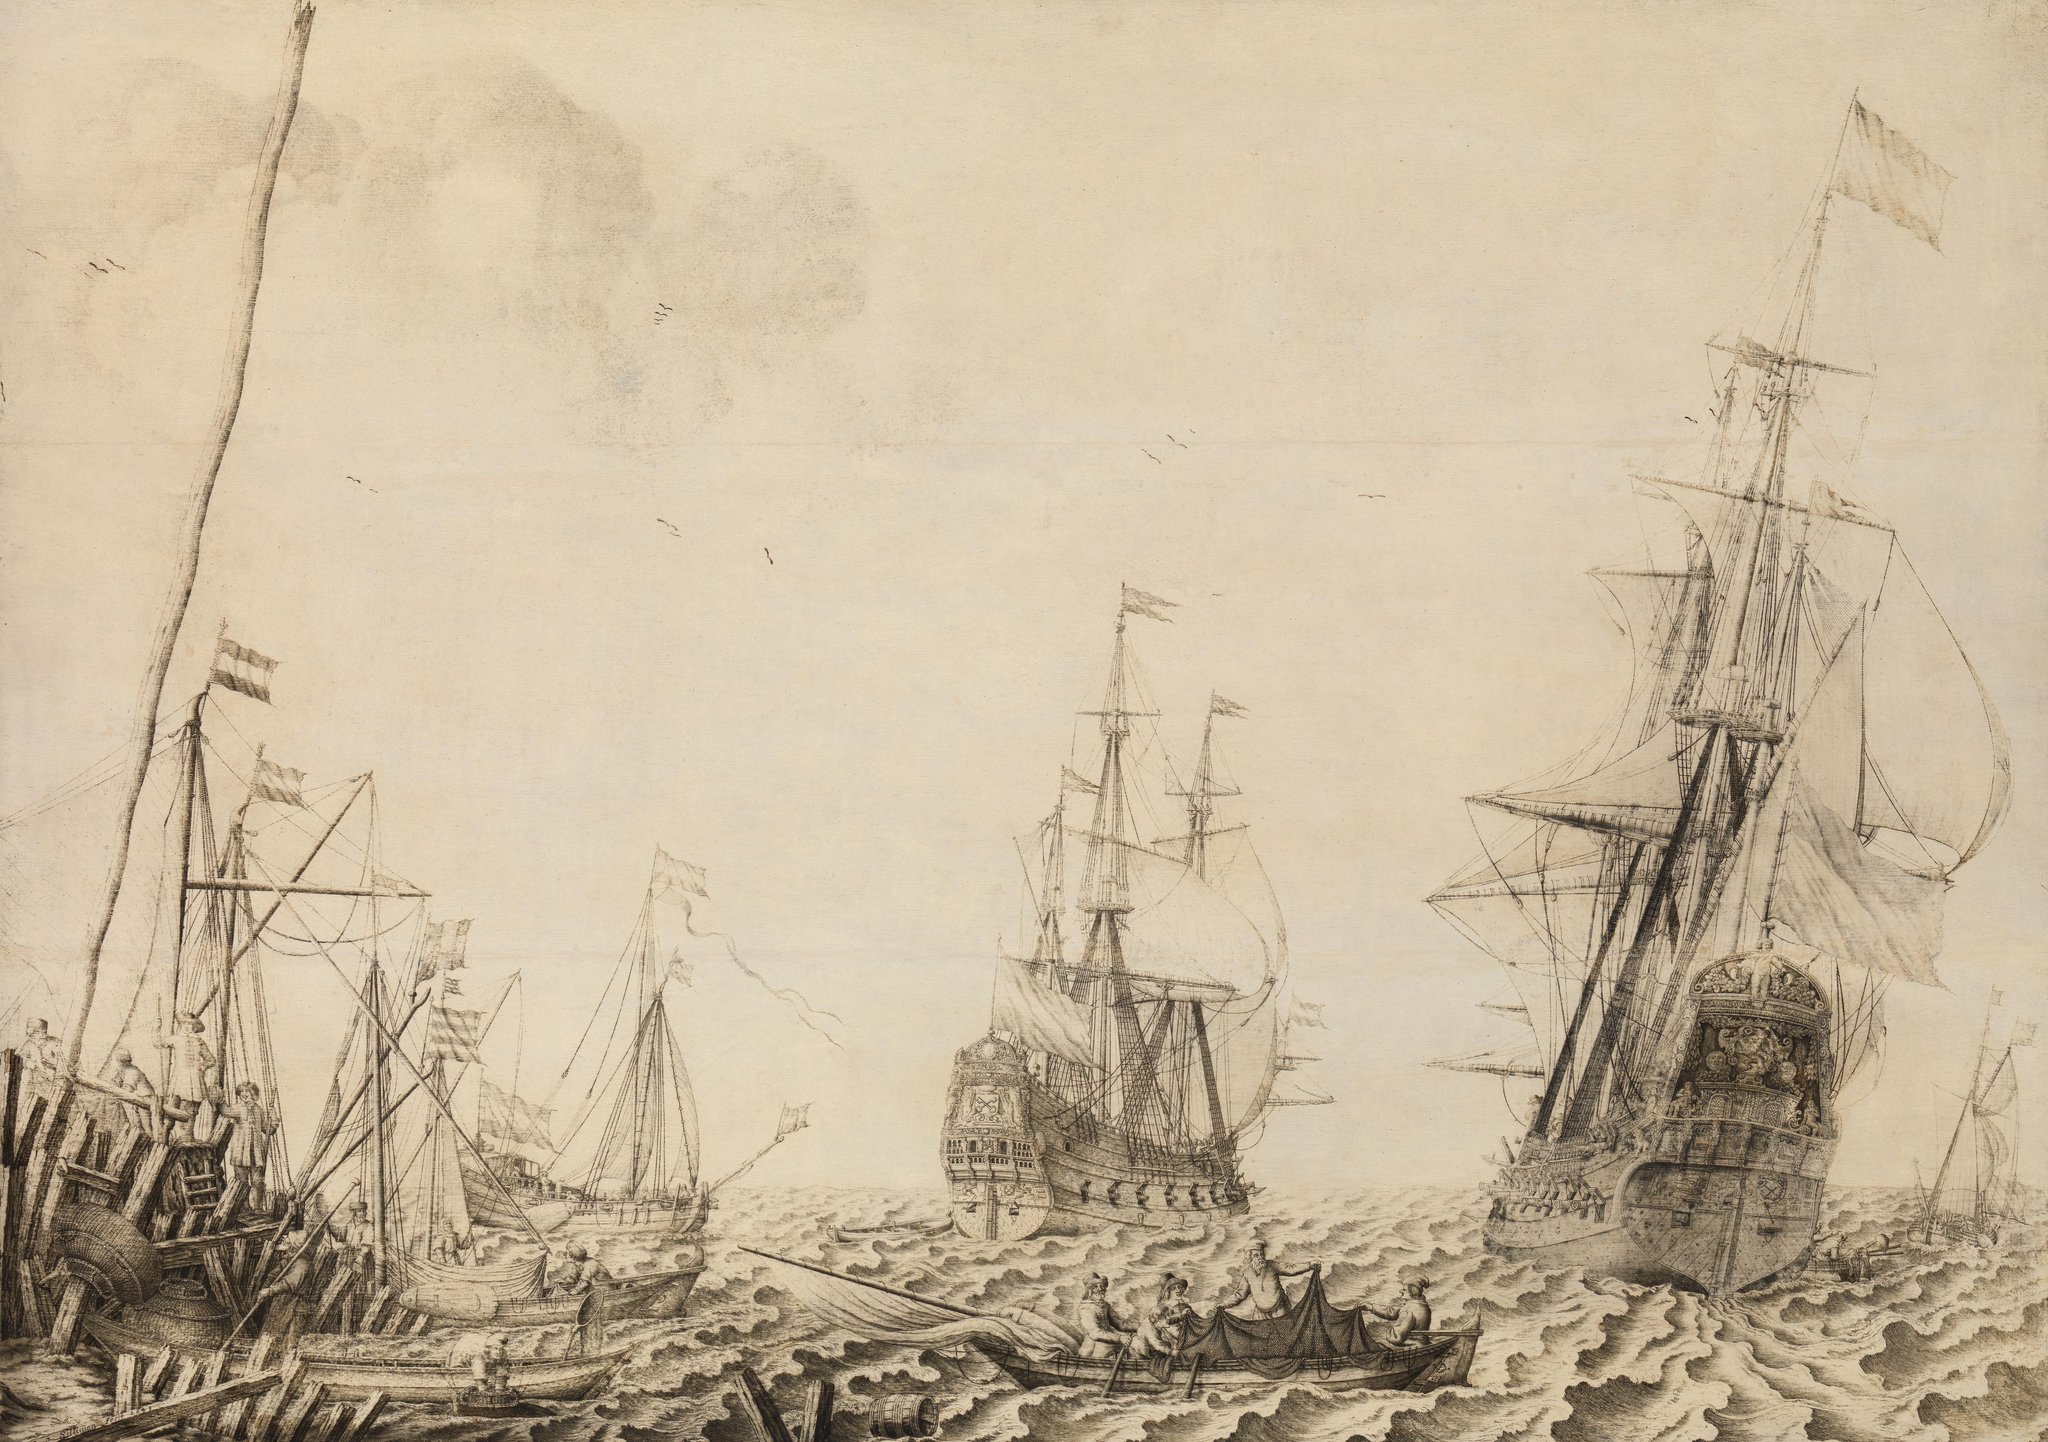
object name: painting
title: Ships near a Harbor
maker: experiens sillemans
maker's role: painter, print maker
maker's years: 1611-1653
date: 1649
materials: ink, panel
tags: harbour, sailing-ship, sailing-boat, pier, quay, wharf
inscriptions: signature and date: ‘Ex.s Silliman Fecit 1649’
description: Zeegezicht met twee Hollandse oorlogsschepen, enkele vissersboten en een jacht, Links een deel van een steiger met enkele mannen. Het schip rechts heeft de Hollandse Leeuw op de spiegel, het andere oorlogsschip het wapen van Leiden.